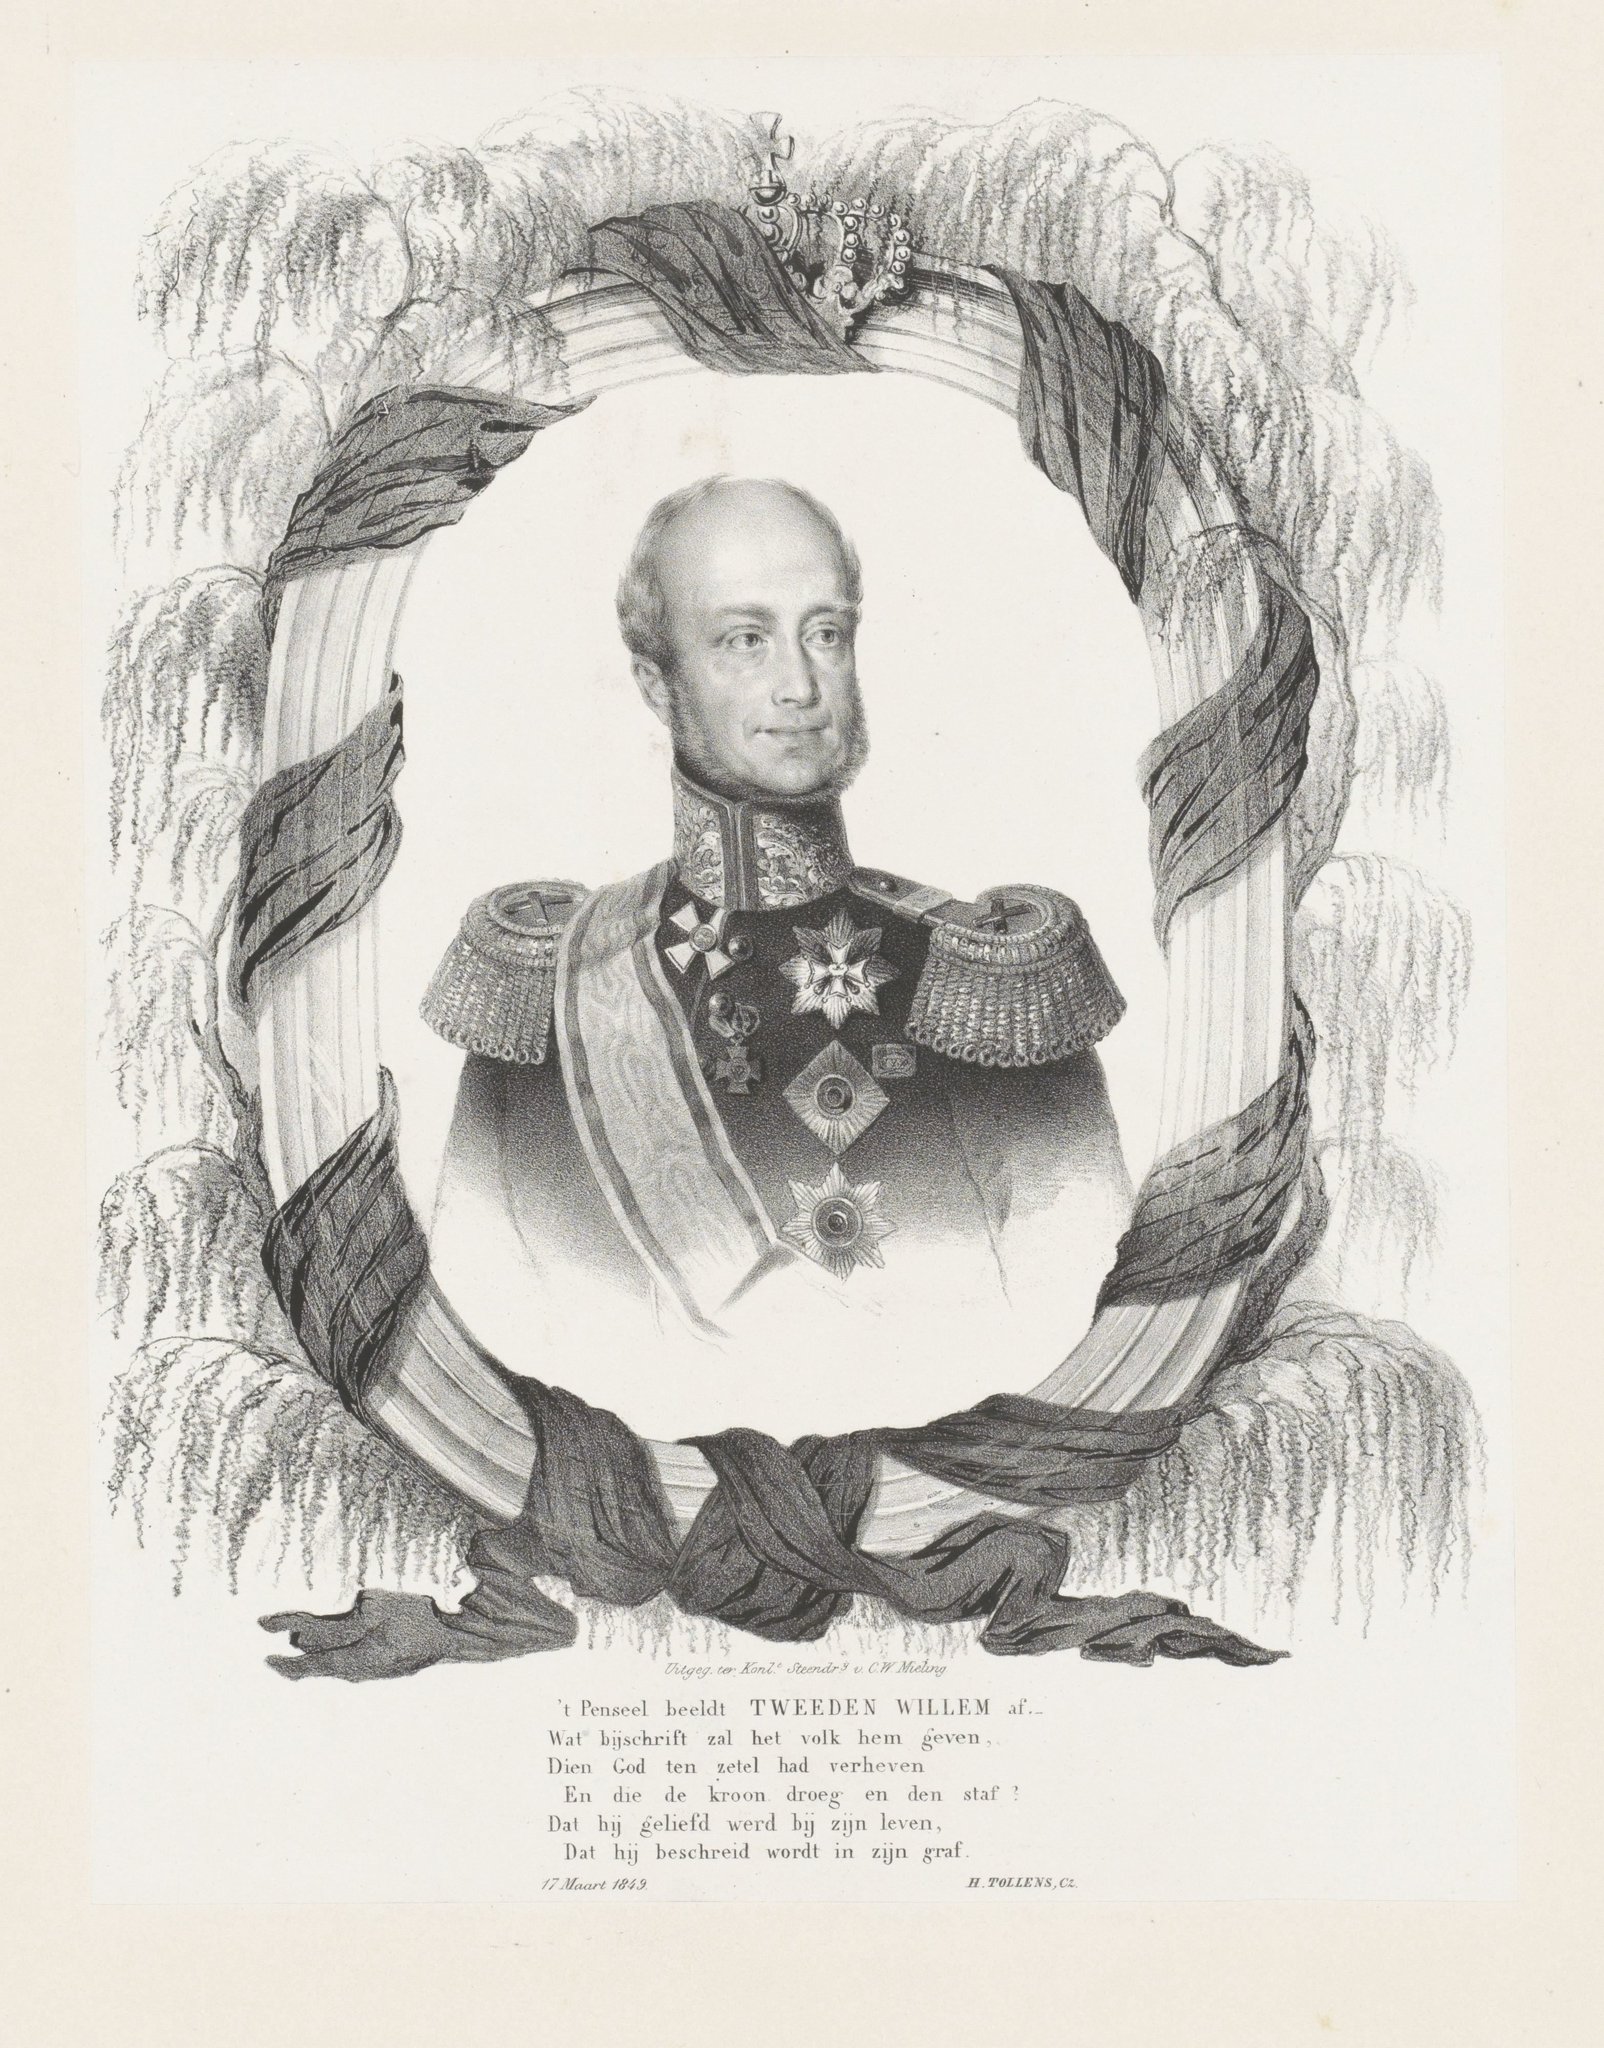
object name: print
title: Portret van Willem II, koning der Nederlanden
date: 1849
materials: paper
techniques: lithograph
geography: netherlands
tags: william ii of the netherlands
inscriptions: date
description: De hier vermelde titel verwijst naar de hoogst verkregen titel van de geportretteerde, niet per se naar de titel die de geportretteerde op deze voorstelling draagt.